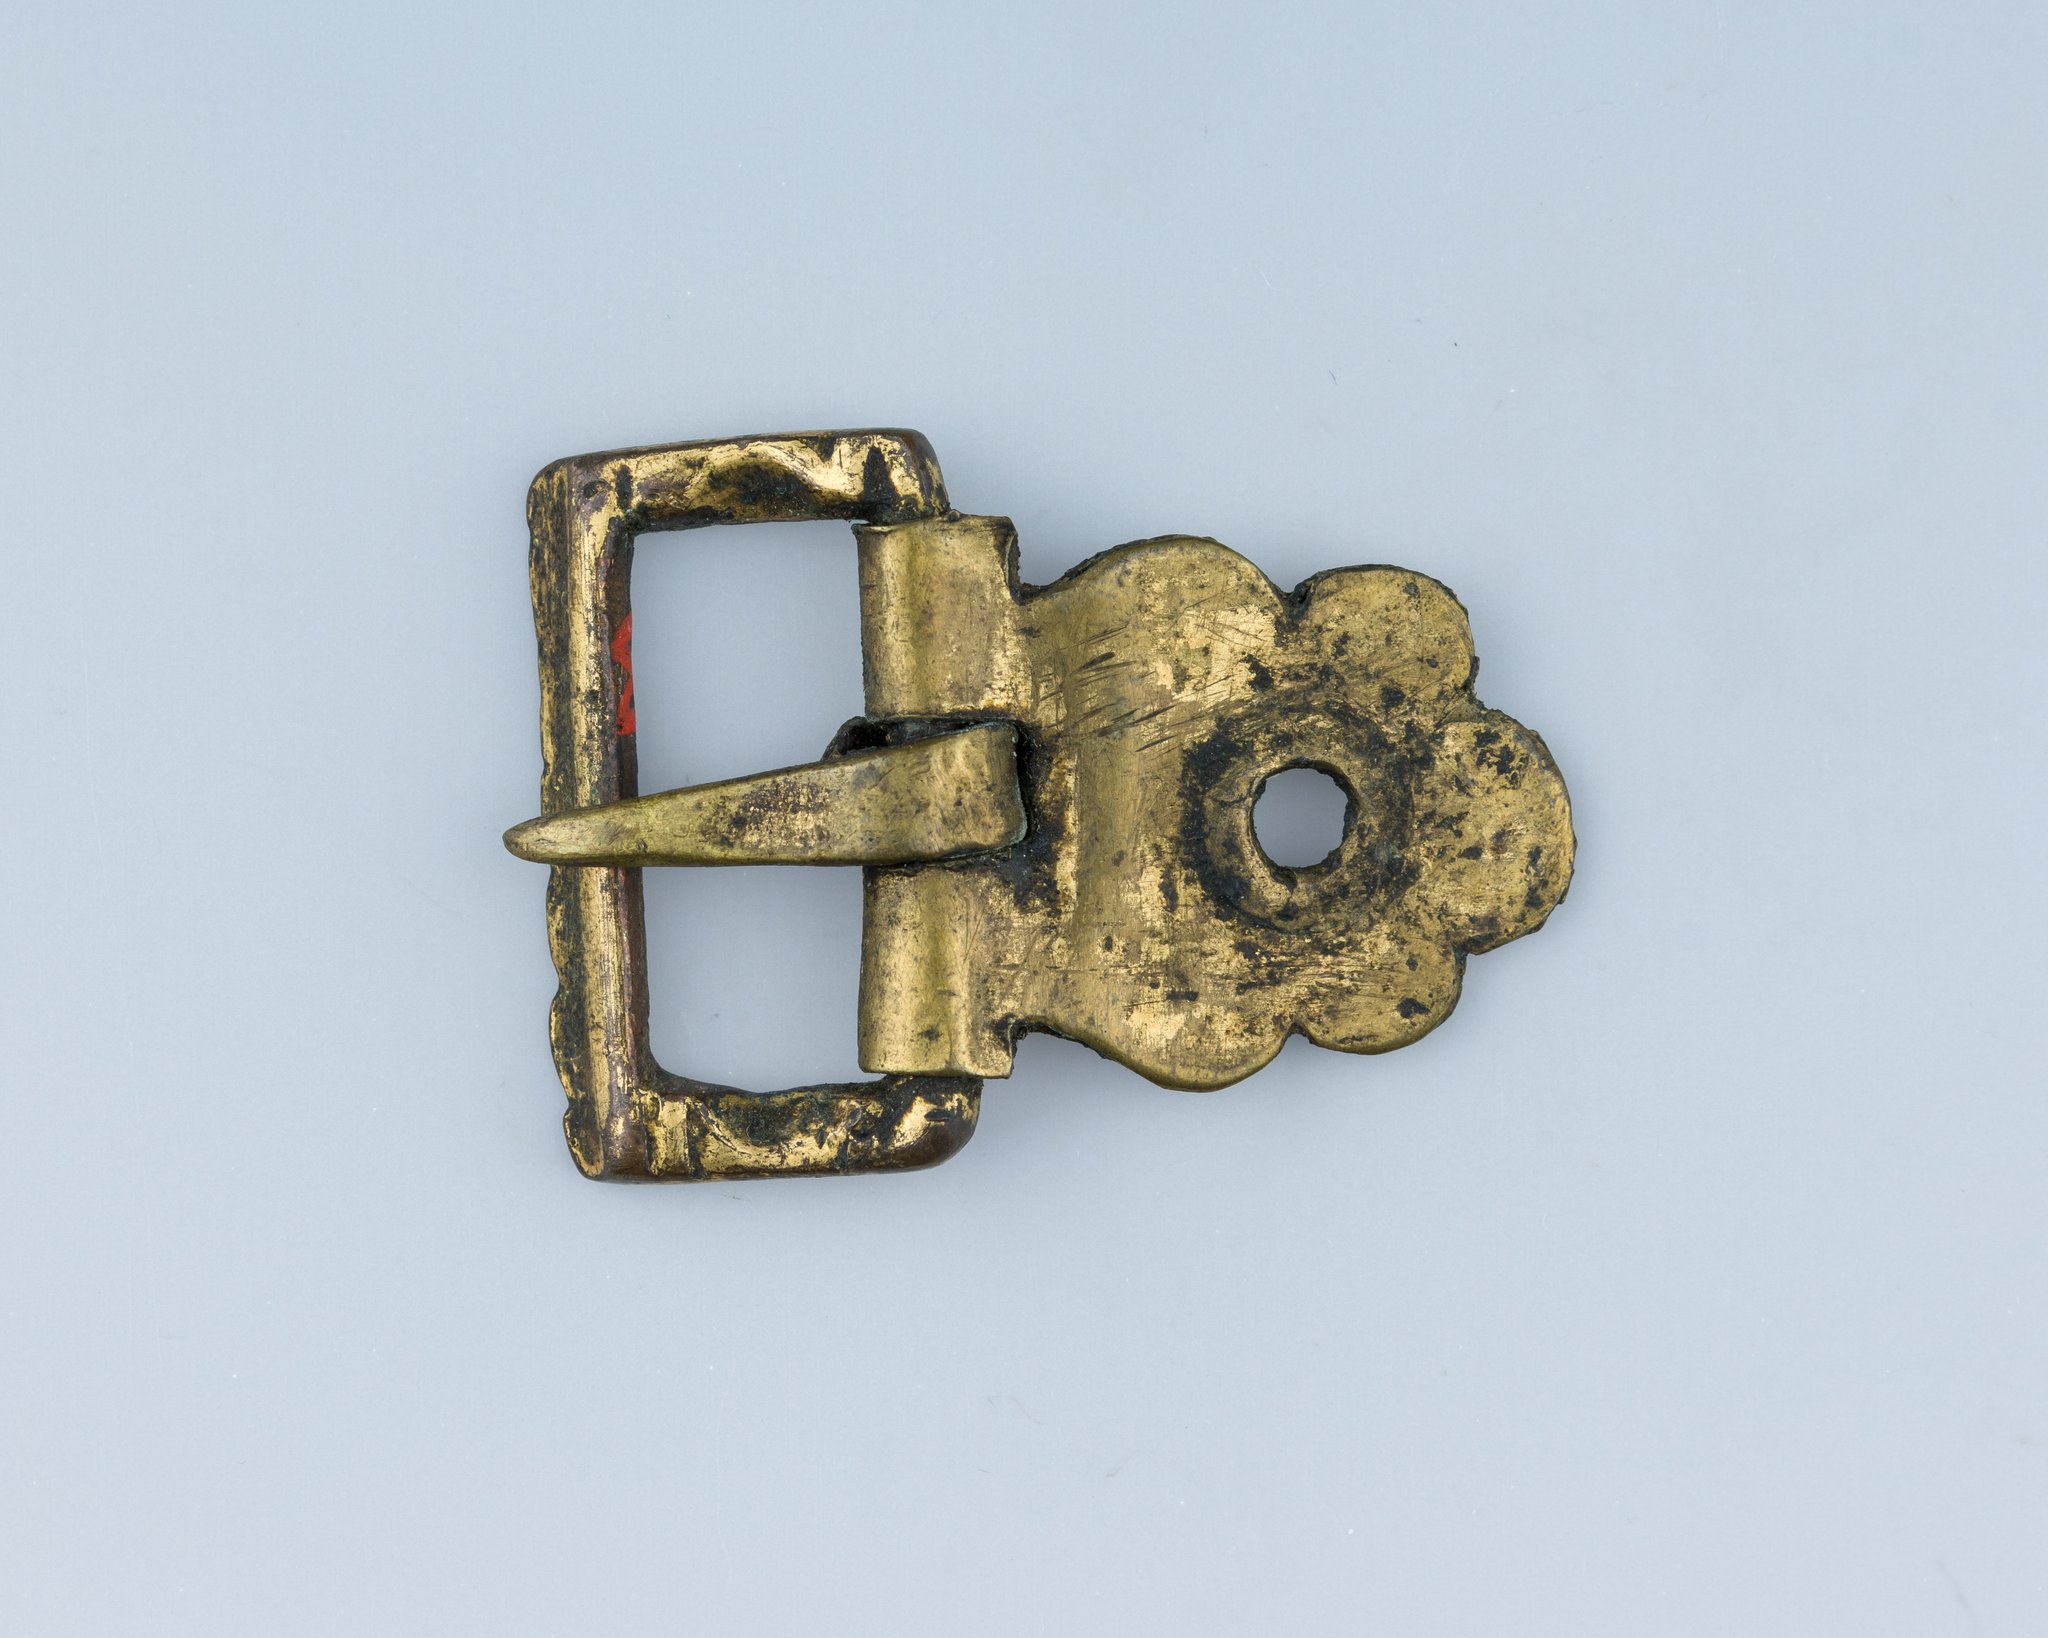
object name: buckle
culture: german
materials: brass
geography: germany